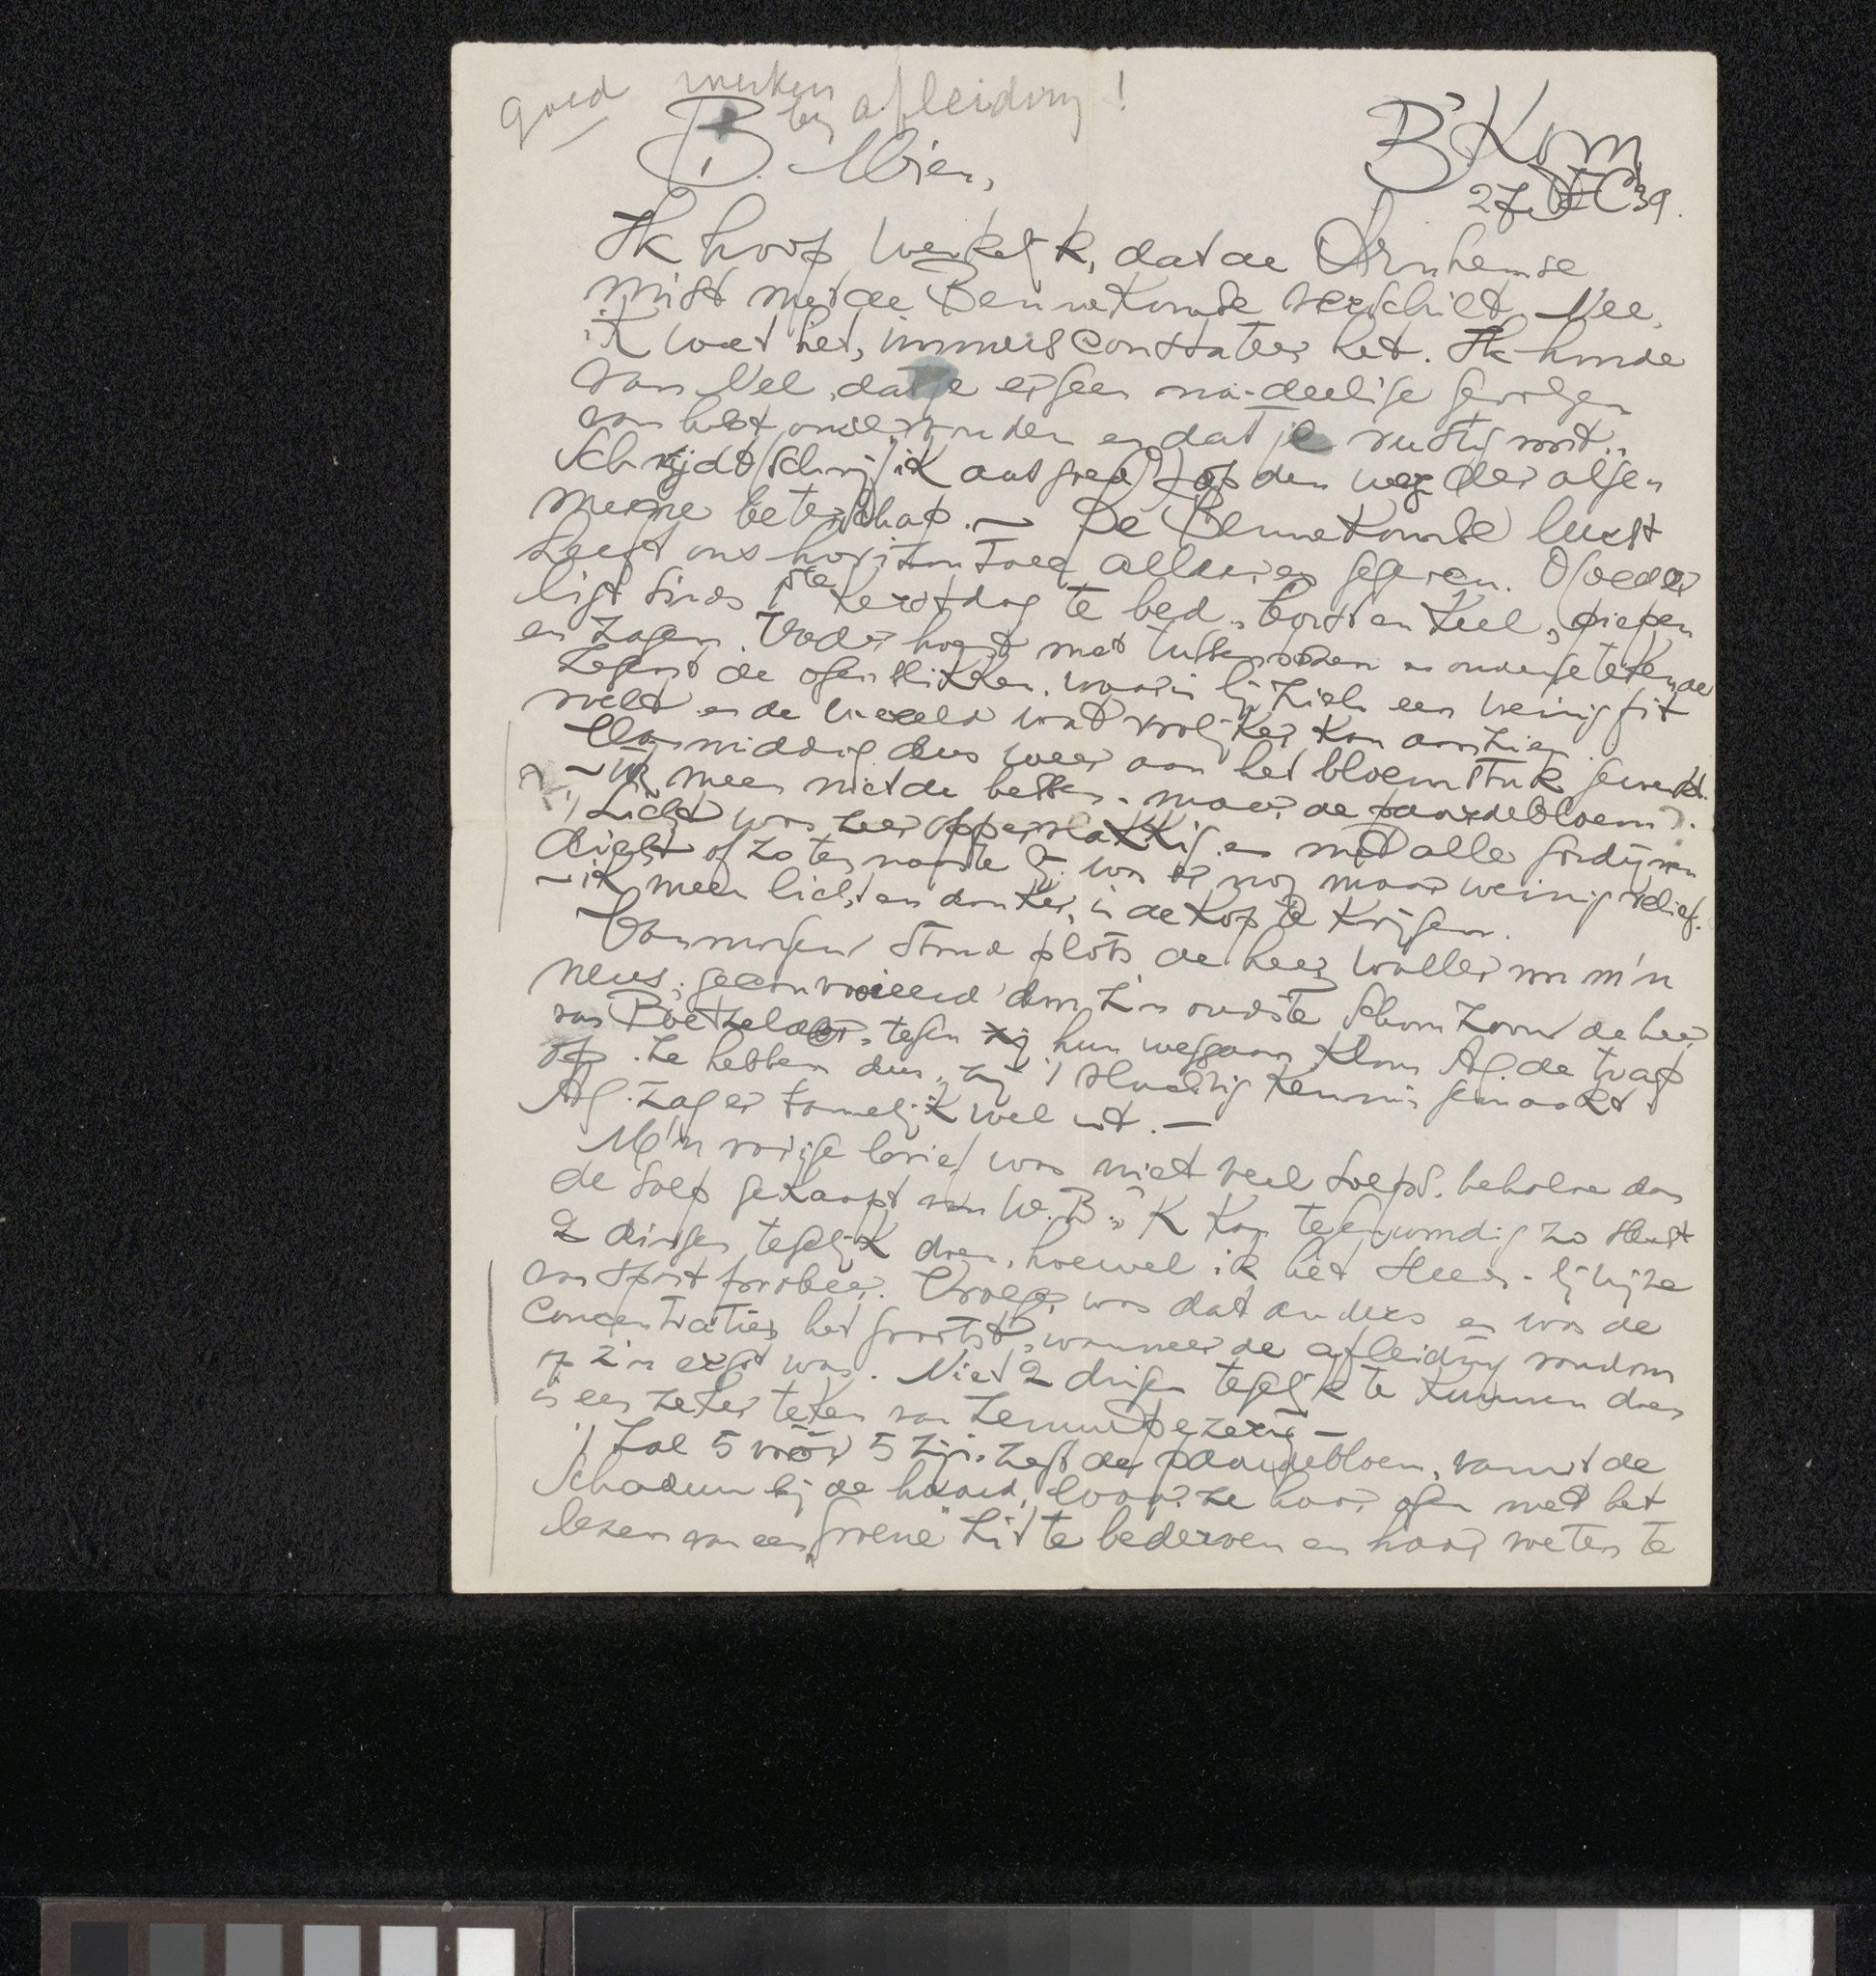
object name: letter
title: Brief aan Mien Cambier van Nooten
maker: dick ket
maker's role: draughtsman, print maker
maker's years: 1902-1940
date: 1939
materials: ink, paper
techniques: pen, writing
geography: bennekom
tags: grave, arnhem, mien cambier van nooten, print maker, marc chagall, portsmouth, literature ~ arts, diseases